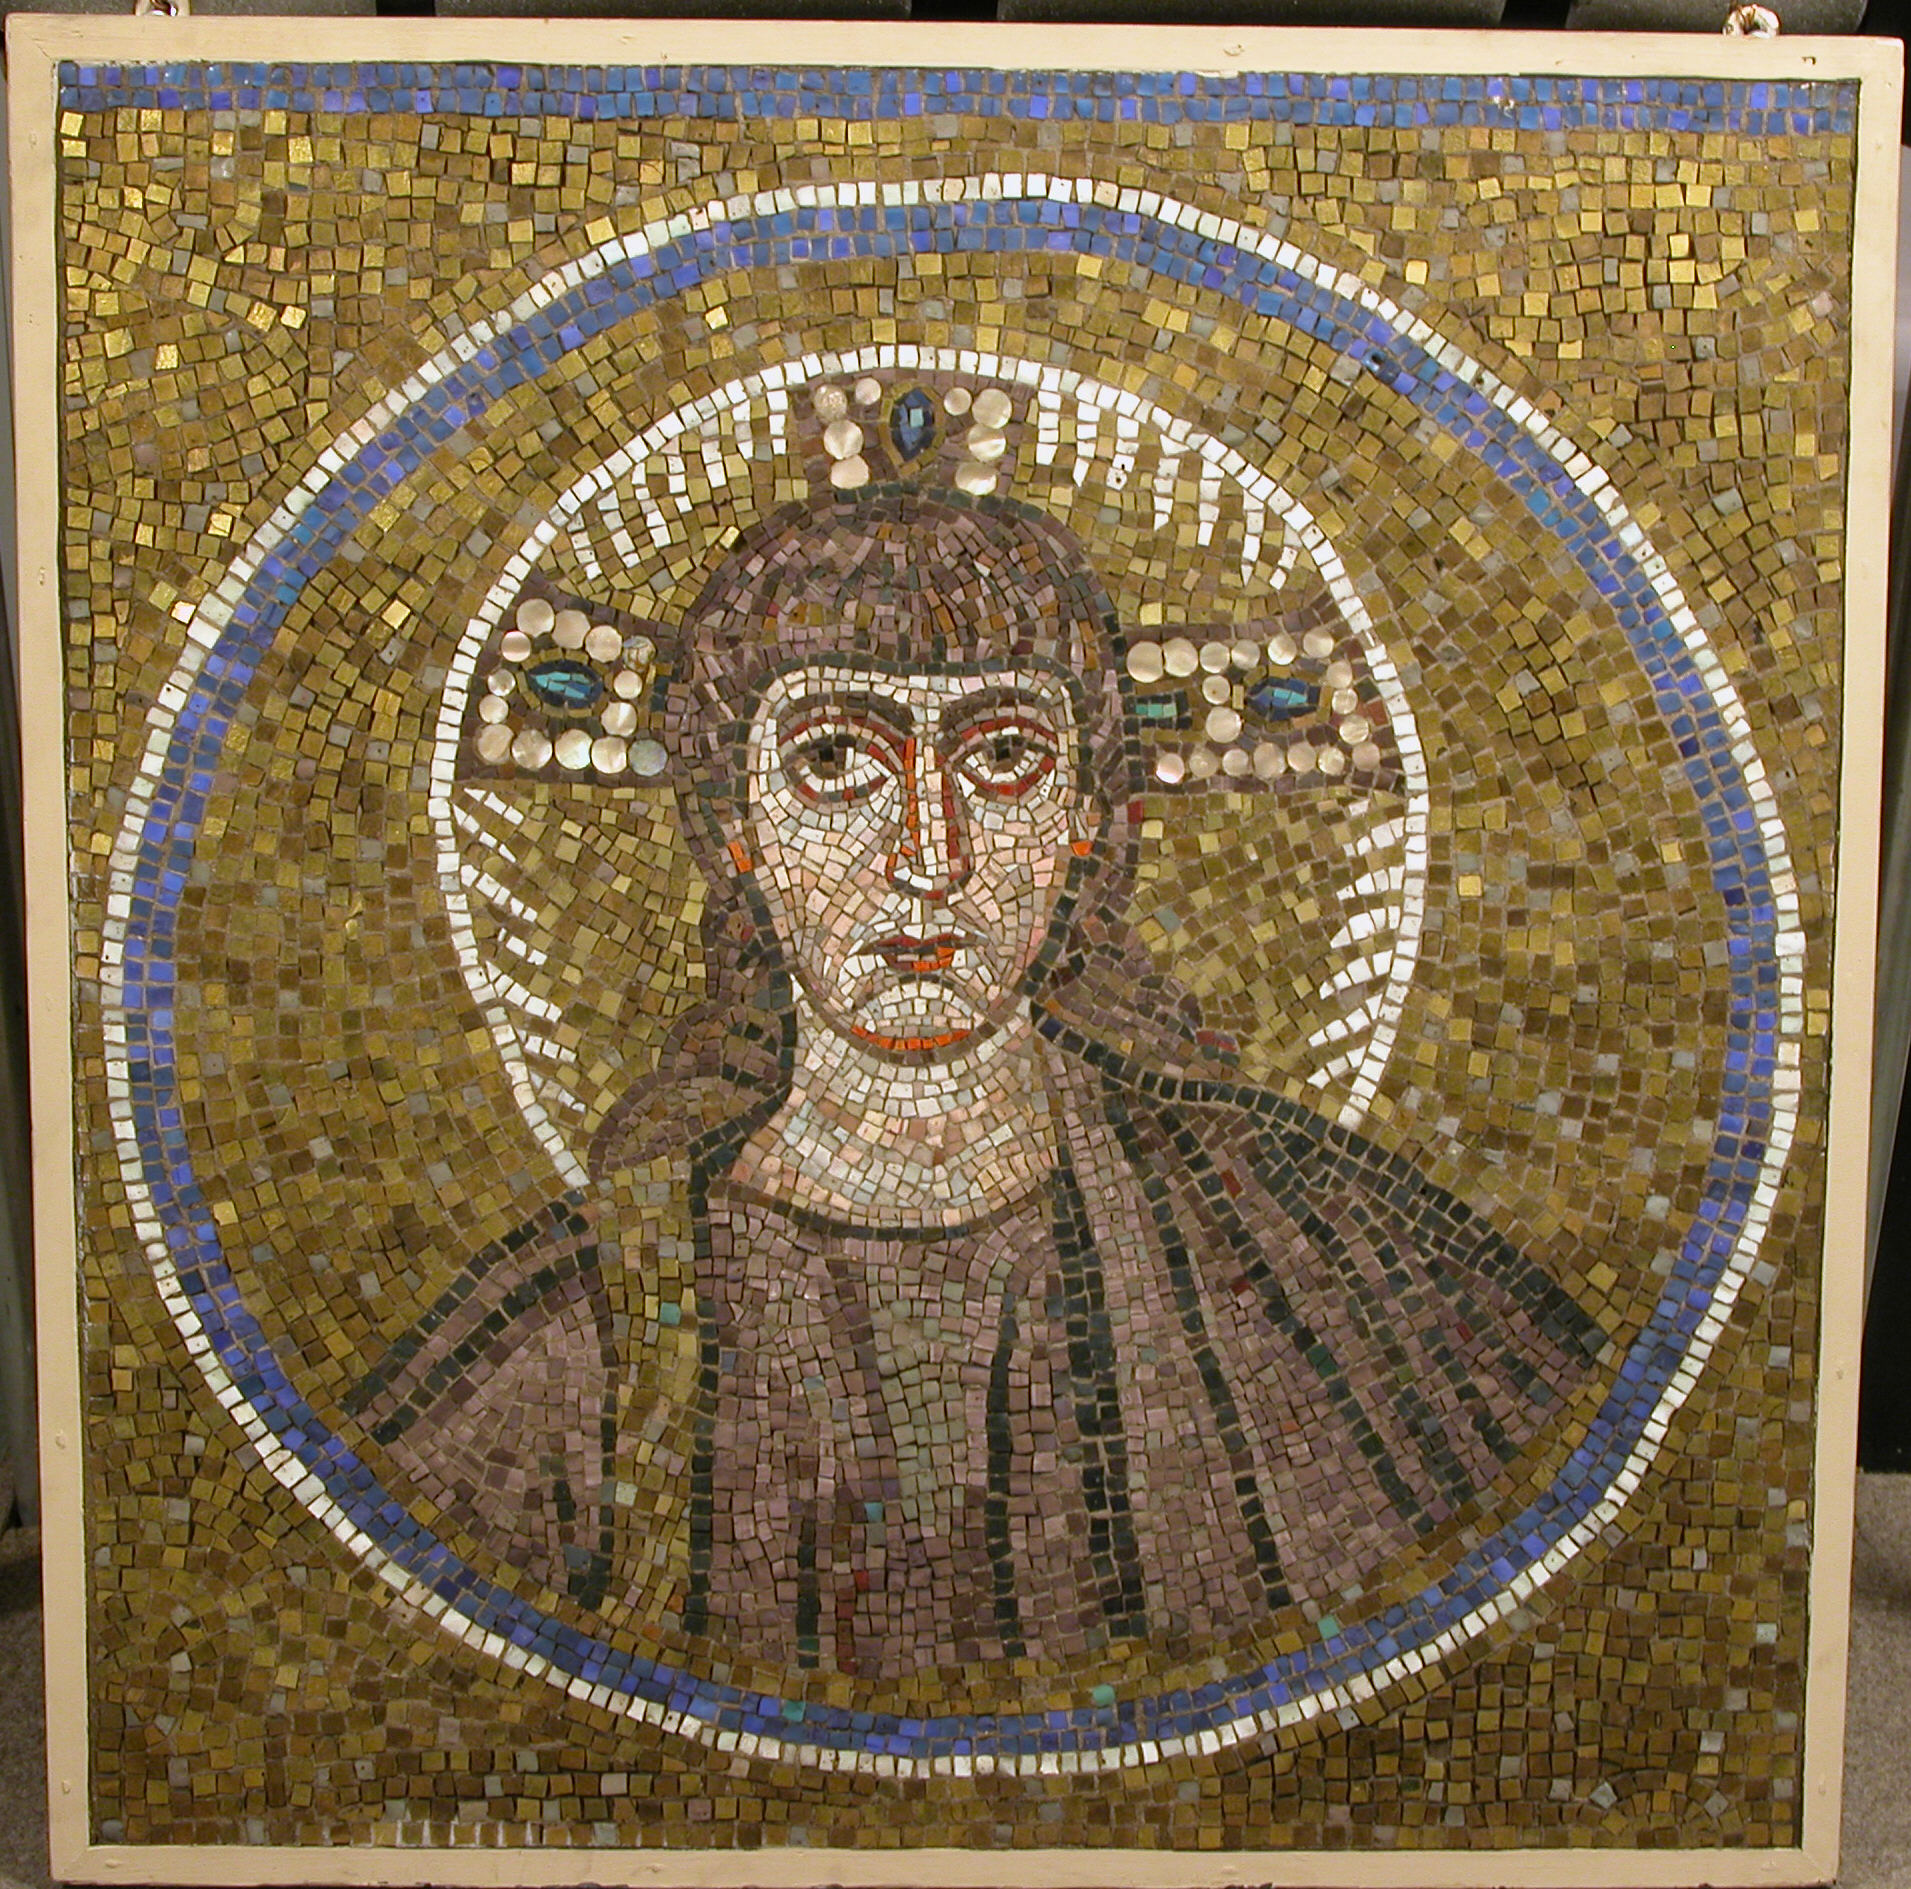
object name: mosaic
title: Portrait of Christ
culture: byzantine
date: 1901-1933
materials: glass